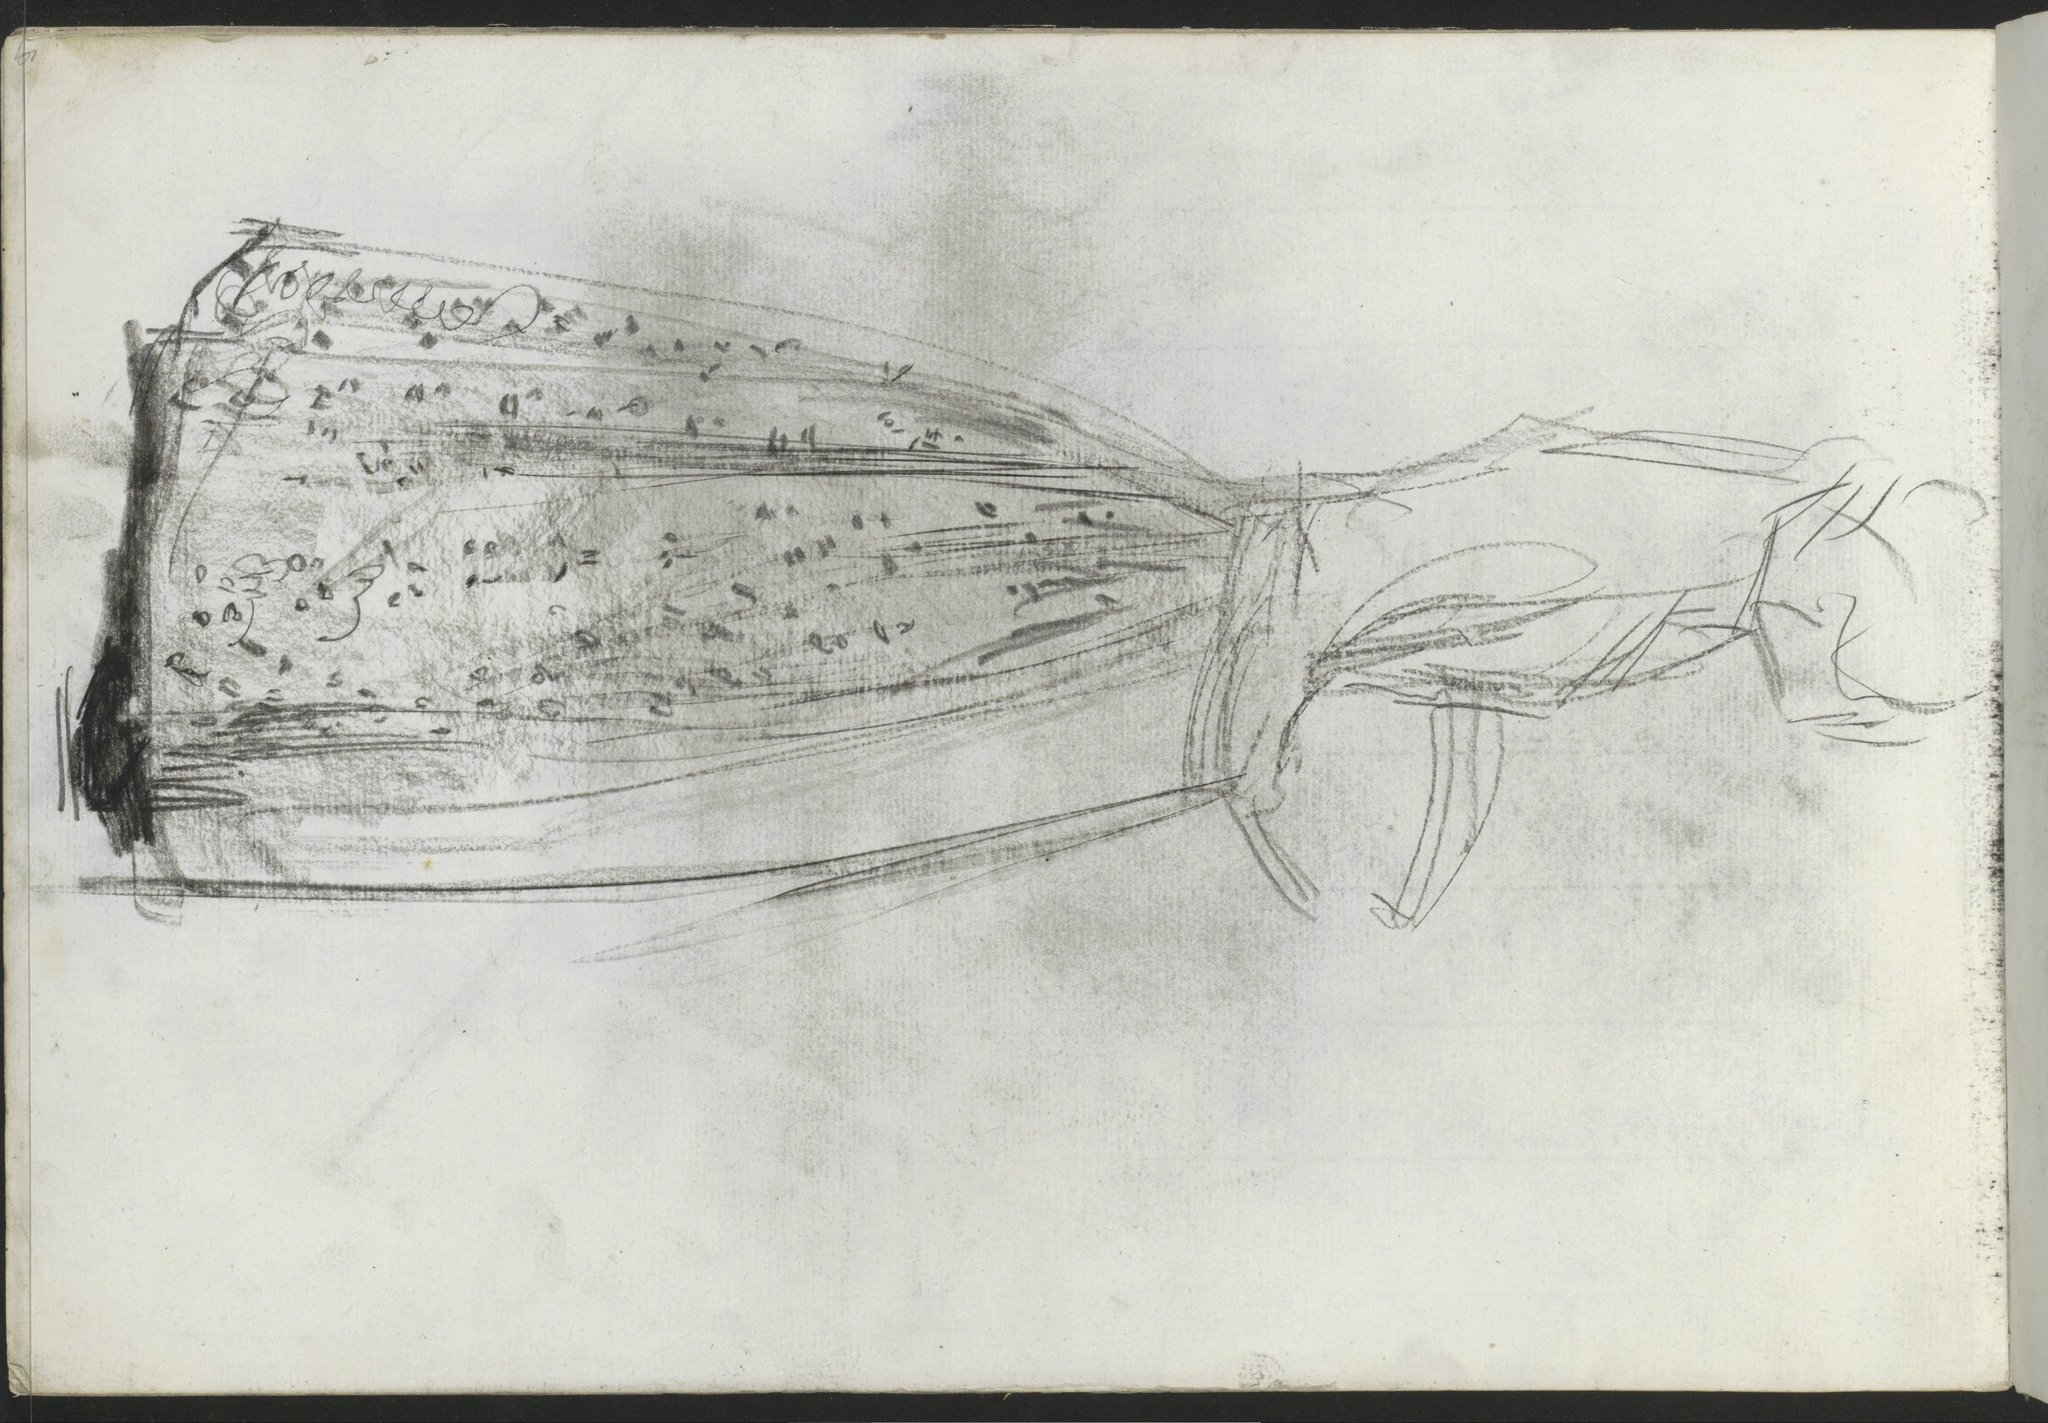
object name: sketchbook leaf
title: Staande vrouw, in profiel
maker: isaac israels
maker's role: draughtsman, painter, print maker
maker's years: 1865-1934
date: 1886-1934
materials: chalk, paper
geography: amsterdam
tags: adult woman (+ standing)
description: Ze houdt mogelijk een voorwerp vast. Blad 16 verso uit schetsboek LXX met 17 bladen.